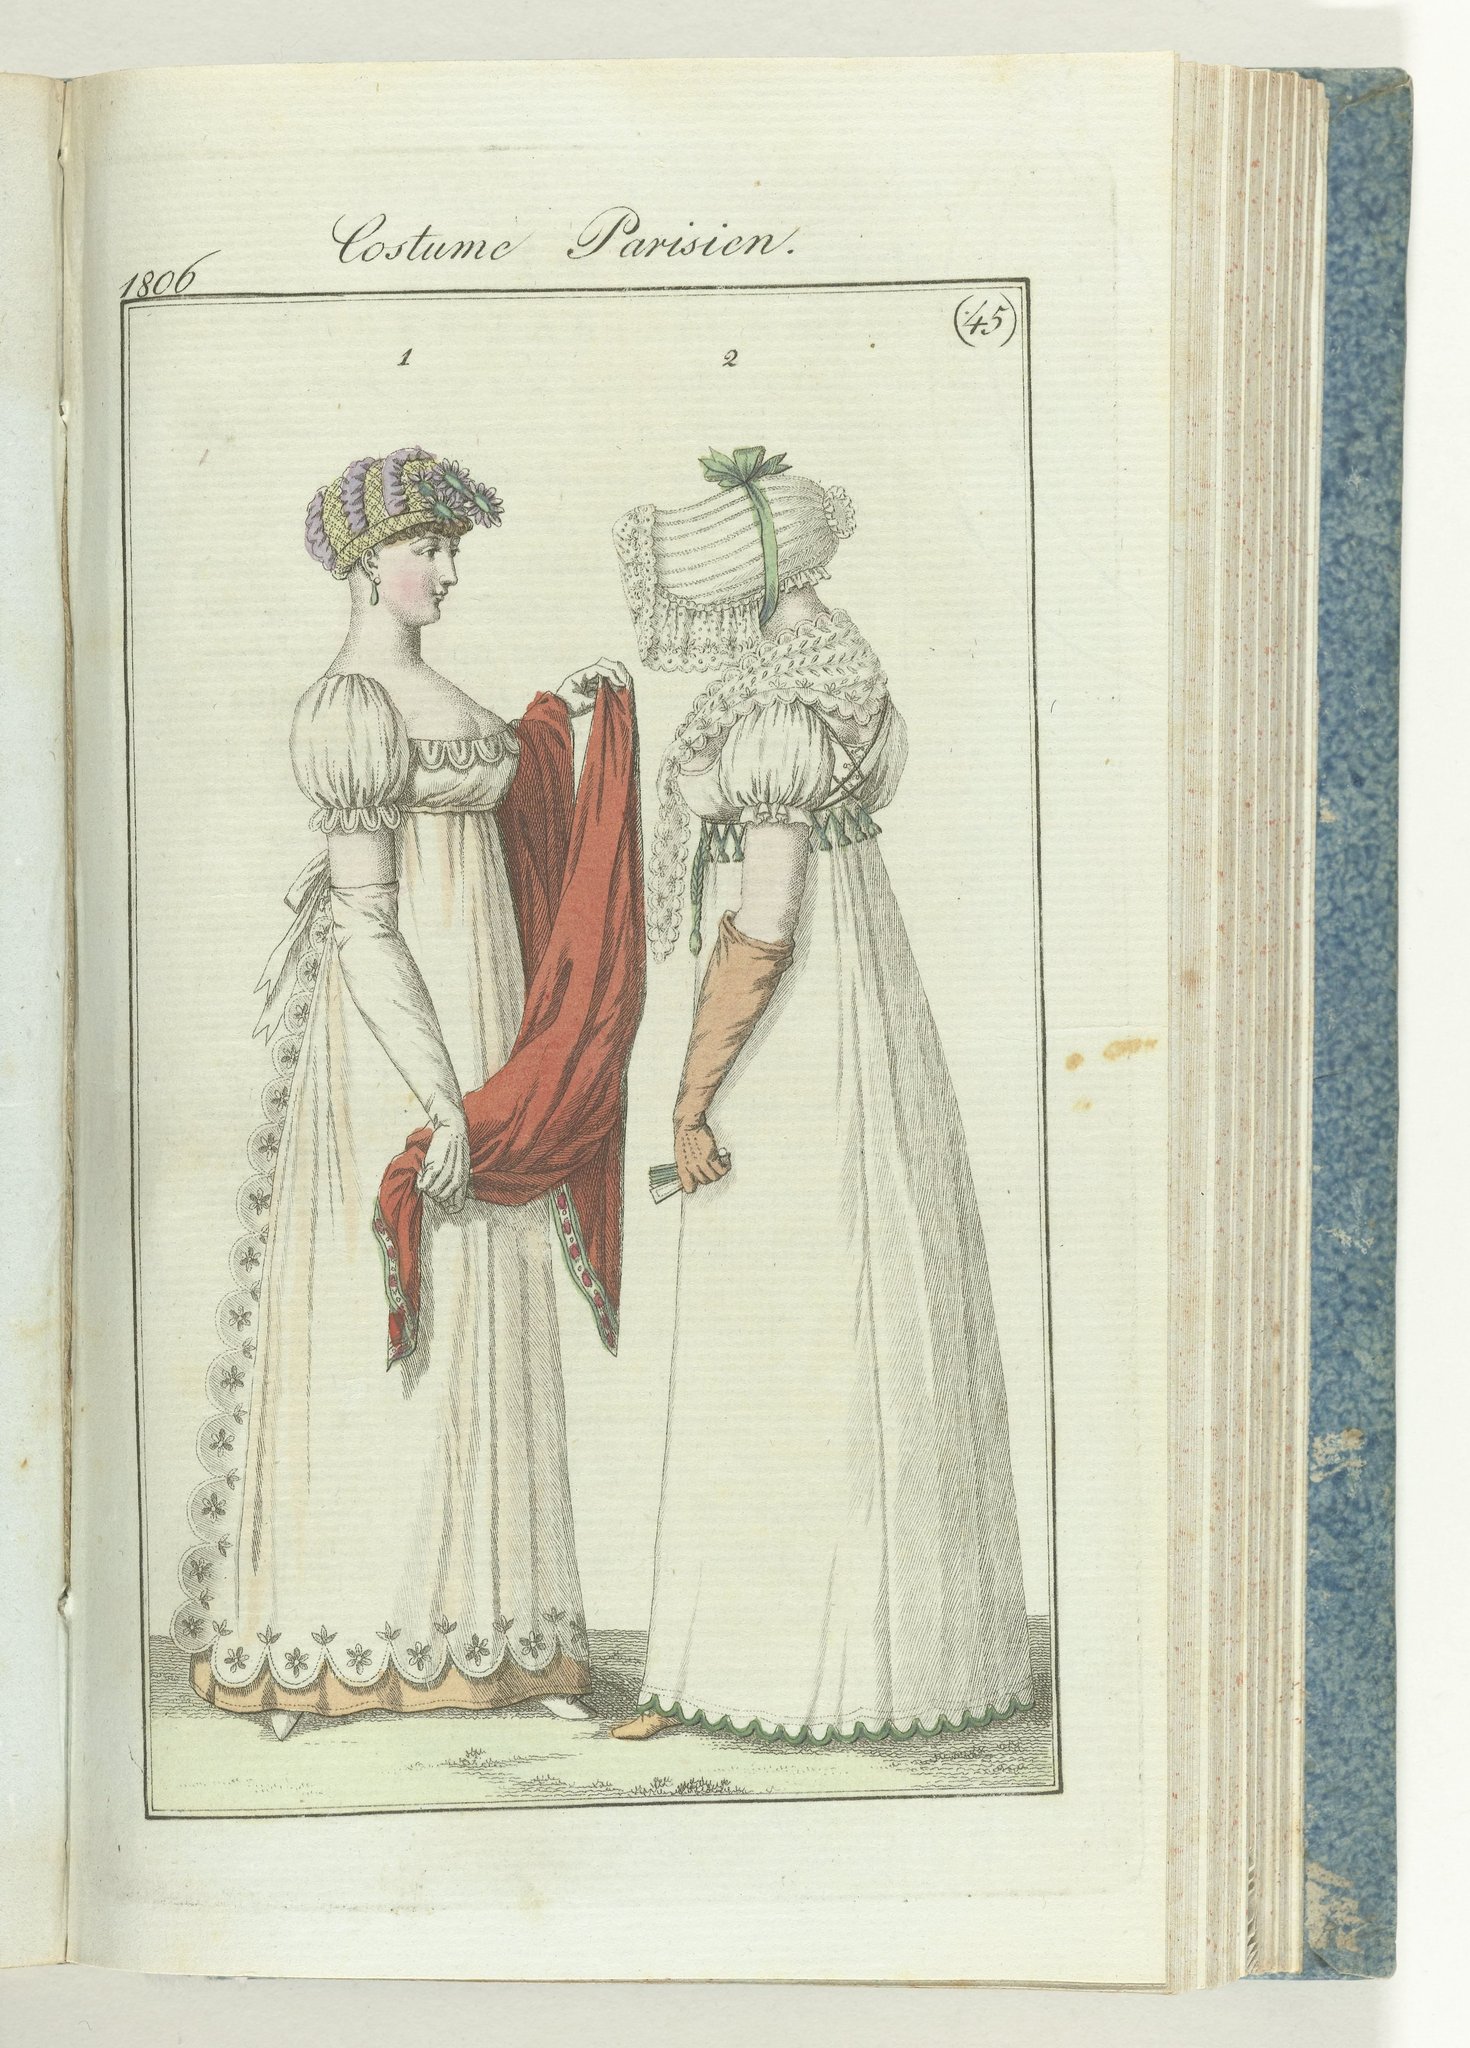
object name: fashion print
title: Journal des Dames et des Modes, editie Frankfurt 3 novembre 1806, Costume Parisien (45)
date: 1806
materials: paper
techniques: engraving, hand coloring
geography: frankfurt am main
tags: ear-rings (+ women's clothes), head-gear (capote) (+ women's clothes), gloves, mittens (long gloves) (+ women's clothes), neck-gear ~ clothing (shawl) (+ women's clothes), fashion plates, head-gear: hat (+ women's clothes), apron (+ women's clothes), sleeves (+ women's clothes), belt, girdle, waistband (+ women's clothes)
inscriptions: title: ‘Costume Parisien.’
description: Volgens de begeleidende tekst (pp.157-158) : Fig. 1: Hoedje van gevlochten stro en linten van tafzijde. Gouden oorbellen. Schort van mousseline met geborduurde rand op een onderrok van gele zijde. Korte pofmouwen. Zijden sjaal. Witte handschoenen. Witte schoenen. Fig. 2: Luifelhoed van perkale met groen lint onder de kin. Japon van witte mousseline. Korte pofmouwen . Geborduurd fichu. Ceintuur van zijden gevlochten koord. Gele (chamois) handschoenen. Gele schoenen. De prent maakt deel uit van het modetijdschrift Journal des Dames et des Modes, uitgegeven in Frankfurt als kopie van de Franse editie van Pierre de la Mésangère, (1798-1848).